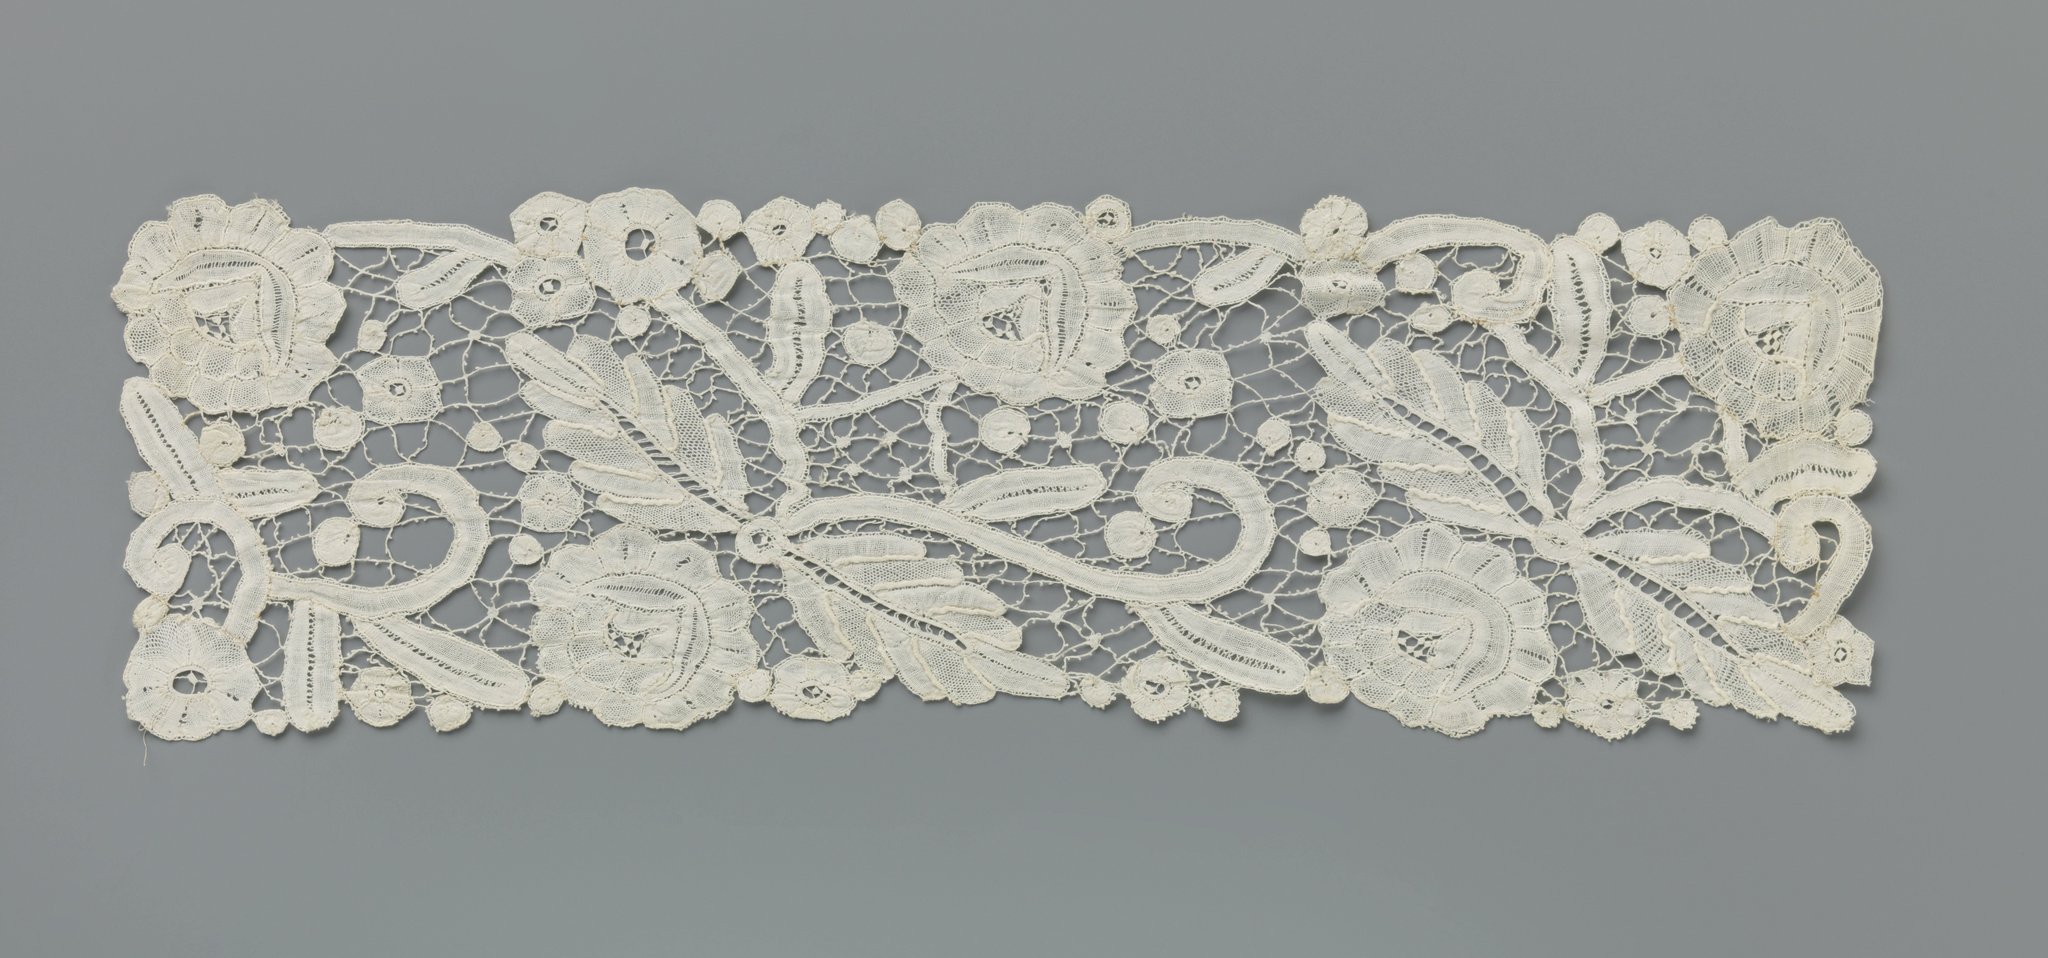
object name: cuff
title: Sierstuk voor een avondmantel van gemengde kant met rozenhaag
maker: martha berkers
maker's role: kantwerkster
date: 1915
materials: linen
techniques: lace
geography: sluis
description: Sierstuk (manchet) voor een avondmantel van gemengde kant - kloskant in combinatie met naaldkant - Brusselse duchesse. Op een wijd gespreide vlechtengrond staan rozen die meestal op twee bladeren steunen. Een tussenornament bestaat uit enkele en dubbele voluutranken en vele kleine bloempjes.